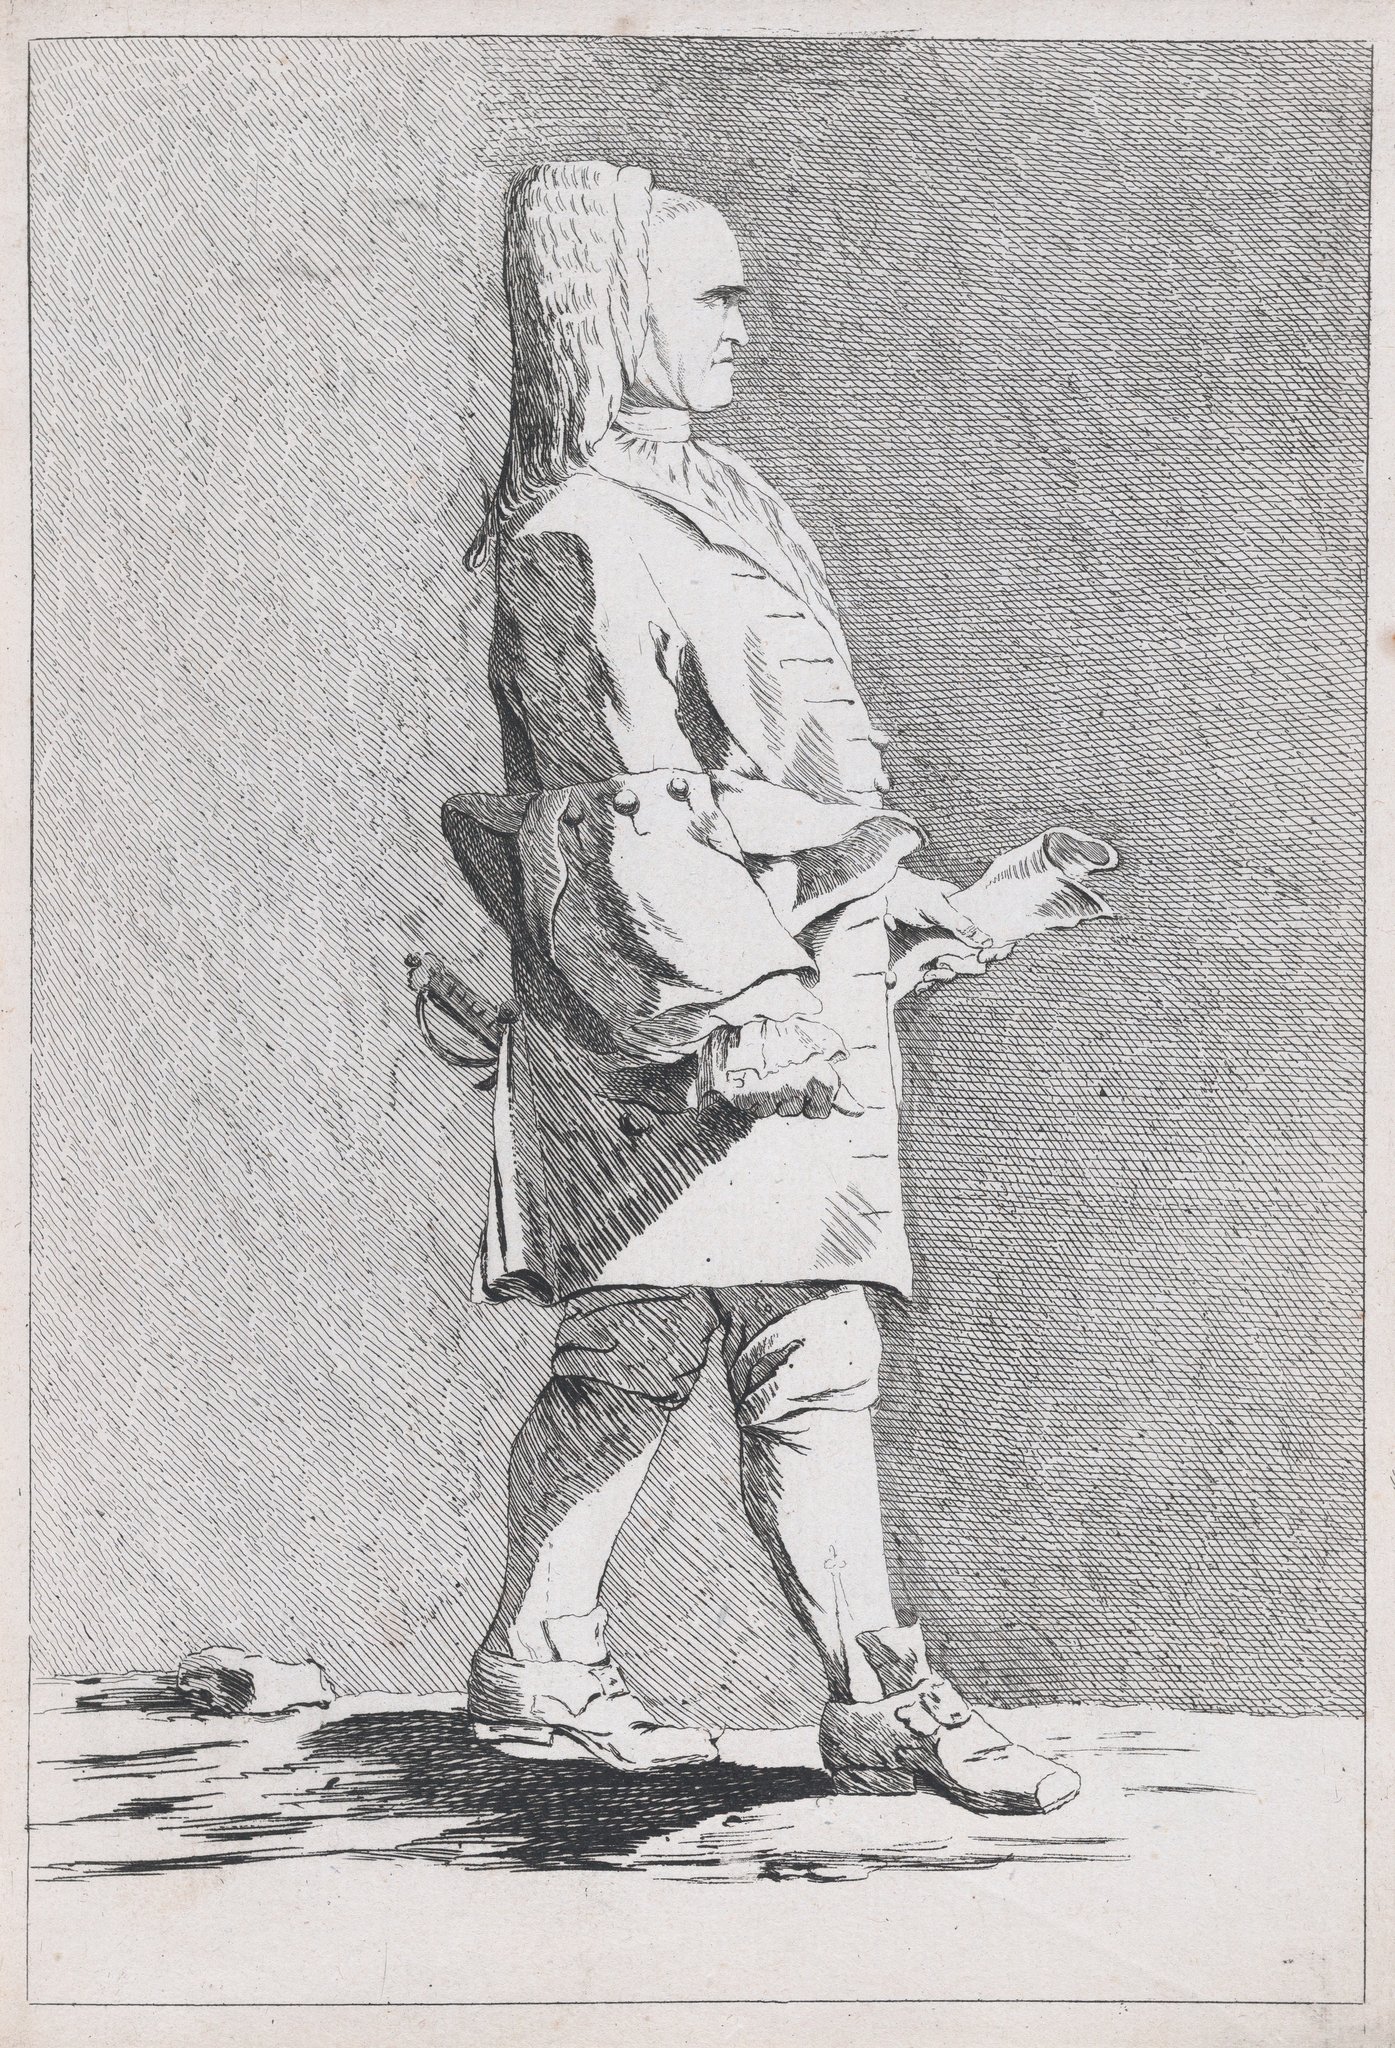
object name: print, album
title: Antoine Deriset, pl. III from "Recueil de caricatures"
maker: ange-laurent de la live de jully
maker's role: artist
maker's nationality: french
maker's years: 1725-1779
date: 1754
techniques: etching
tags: men,caricature